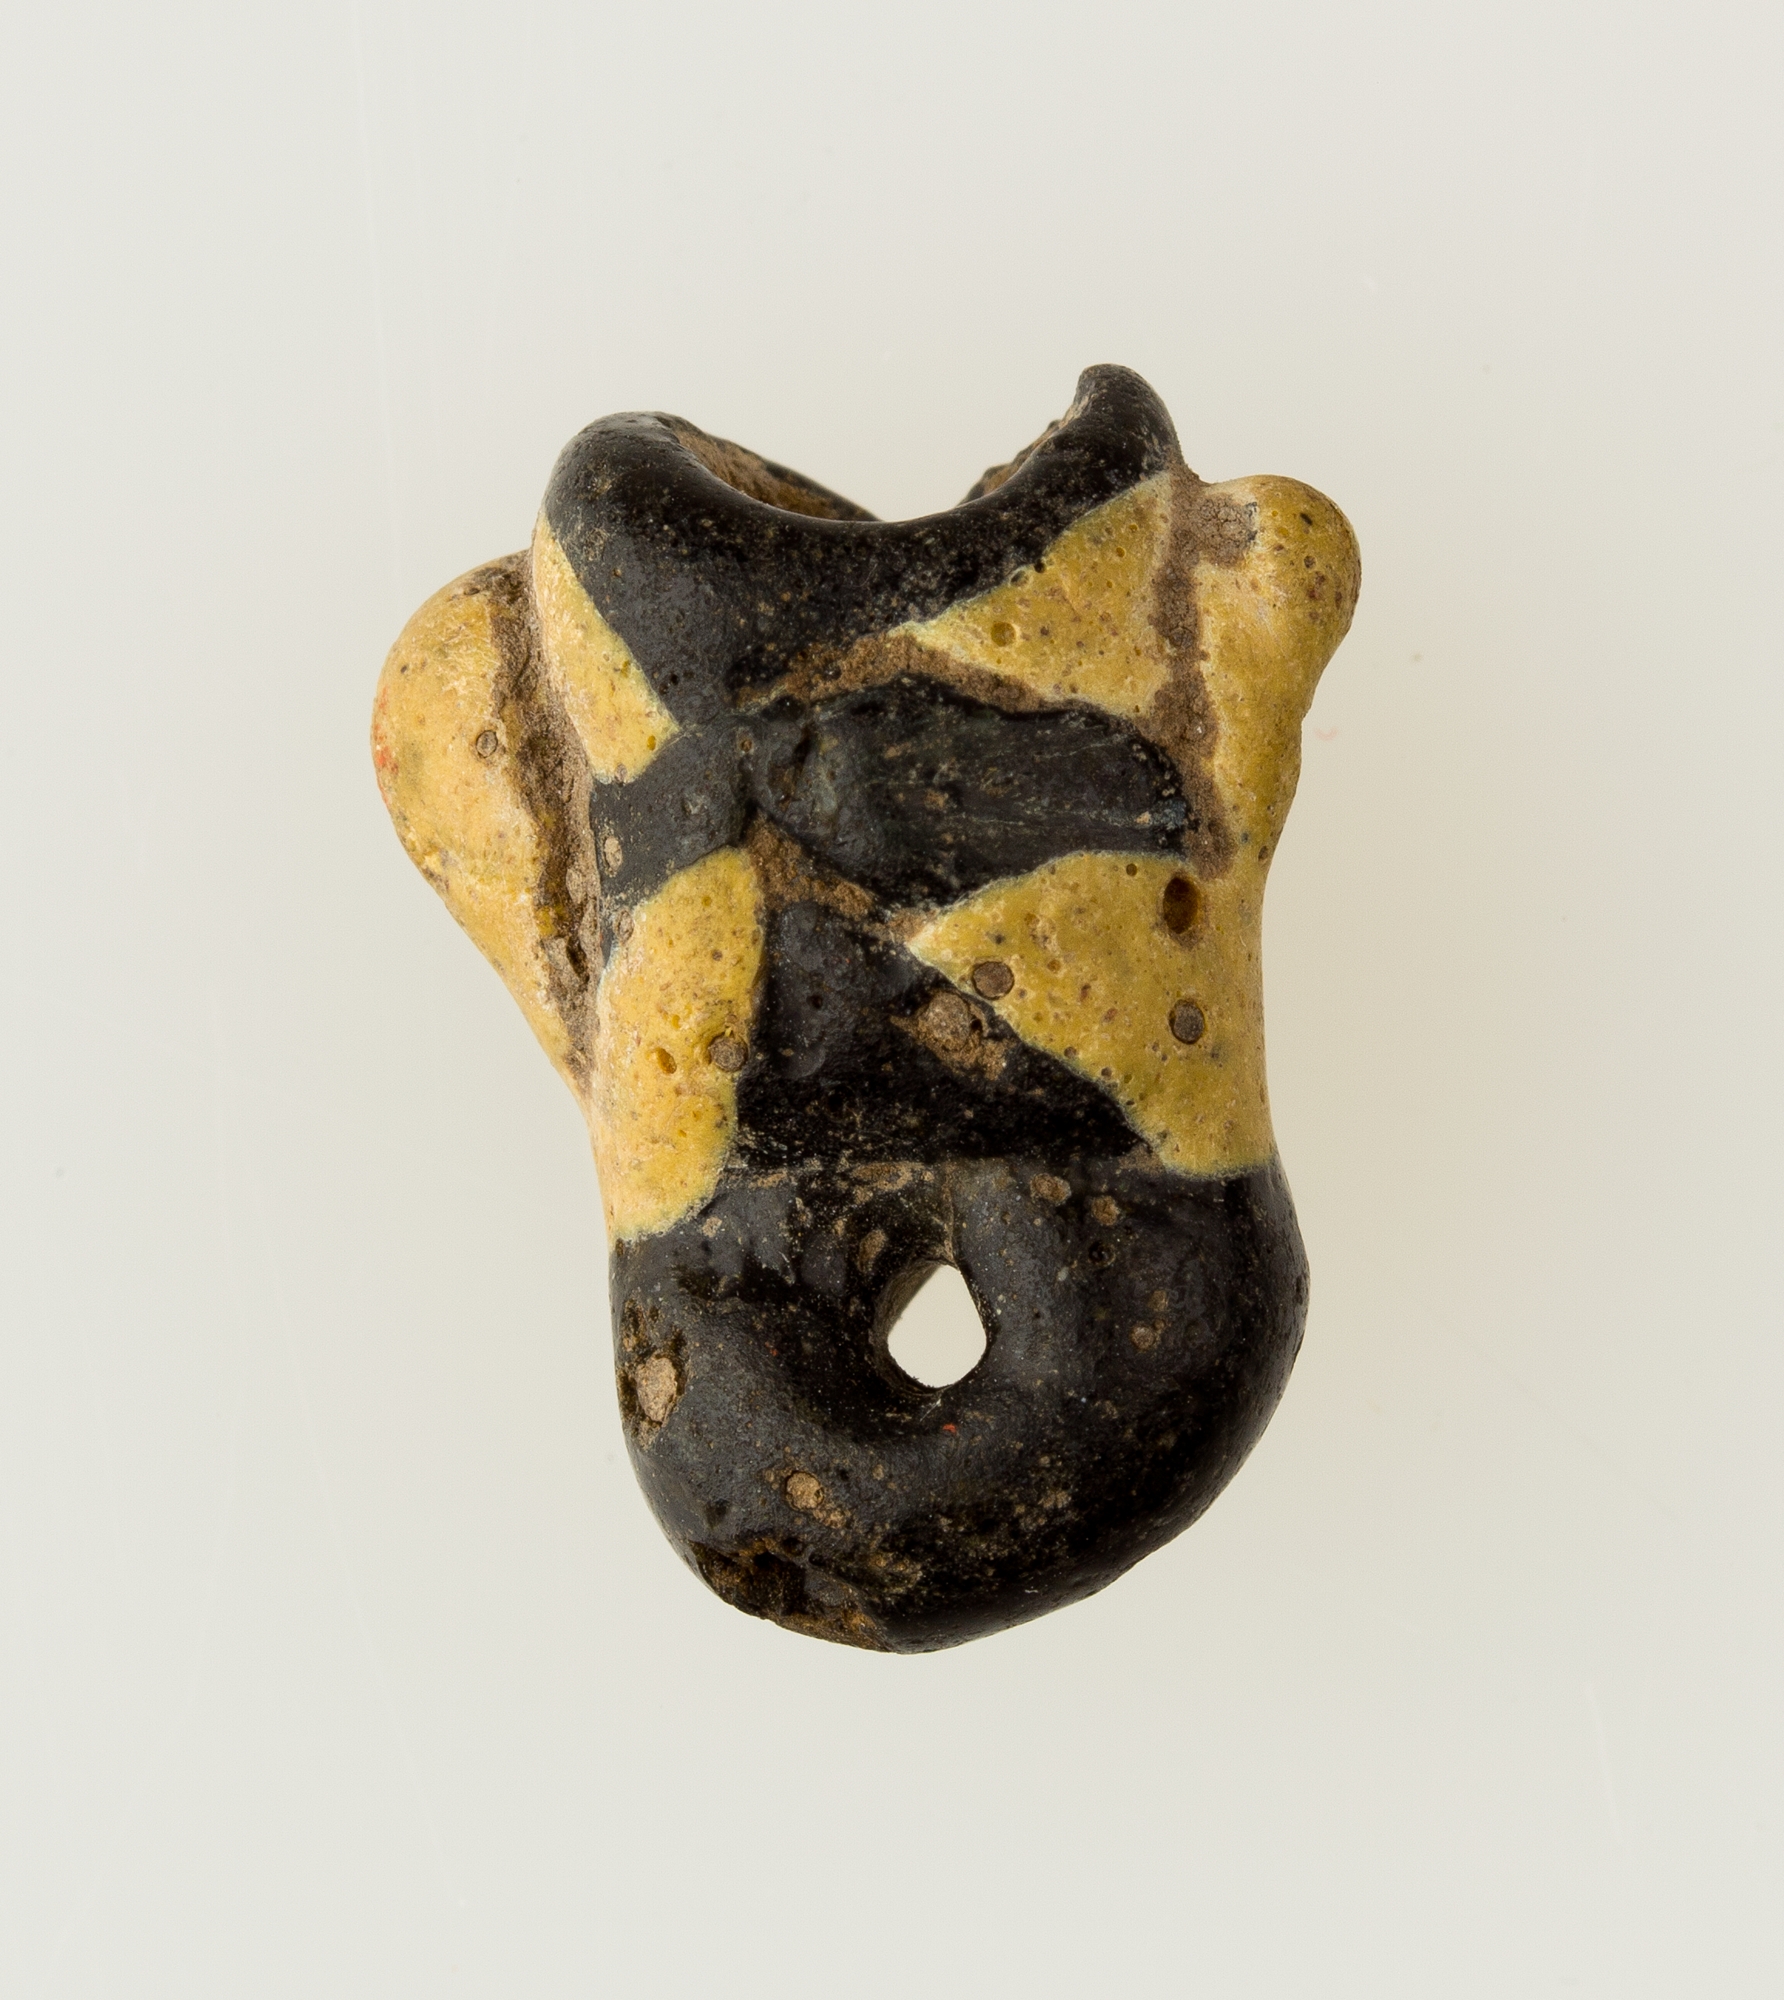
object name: amulet, face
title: Amulet in form of human face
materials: glass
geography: egypt